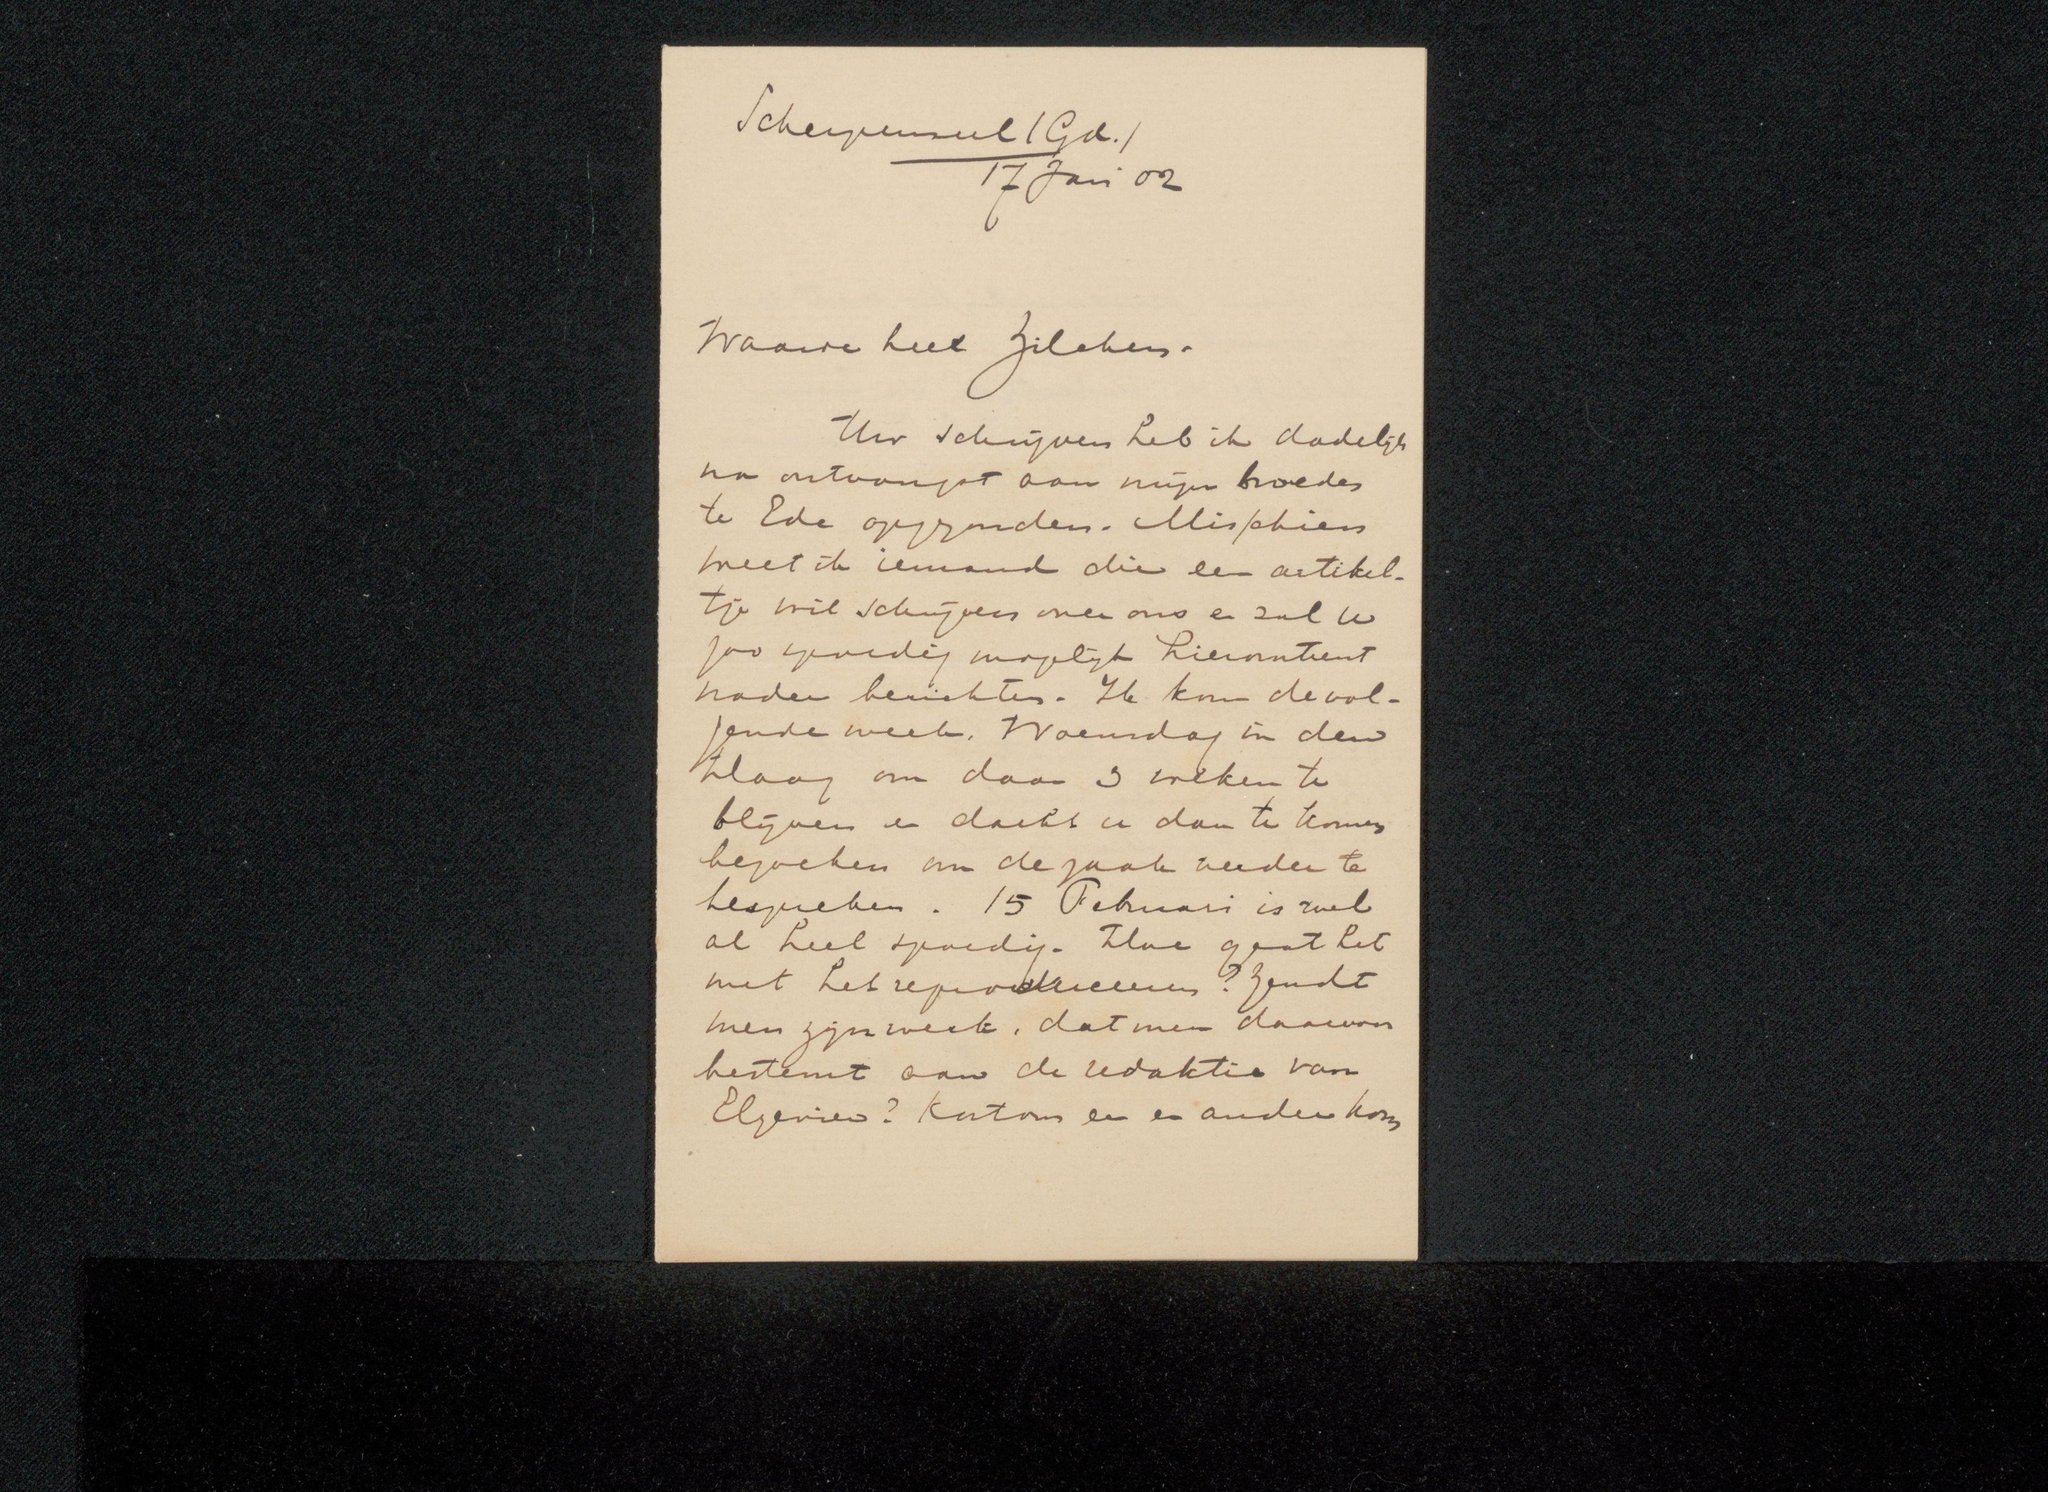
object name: letter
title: Brief aan Philip Zilcken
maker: edzard koning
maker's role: draughtsman, print maker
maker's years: 1869-1954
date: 1902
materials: ink, paper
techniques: pen, writing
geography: scherpenzeel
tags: arnold koning, painter, philip zilcken, the graphic arts, the hague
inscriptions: collector's mark: ‘RPK’, watermark